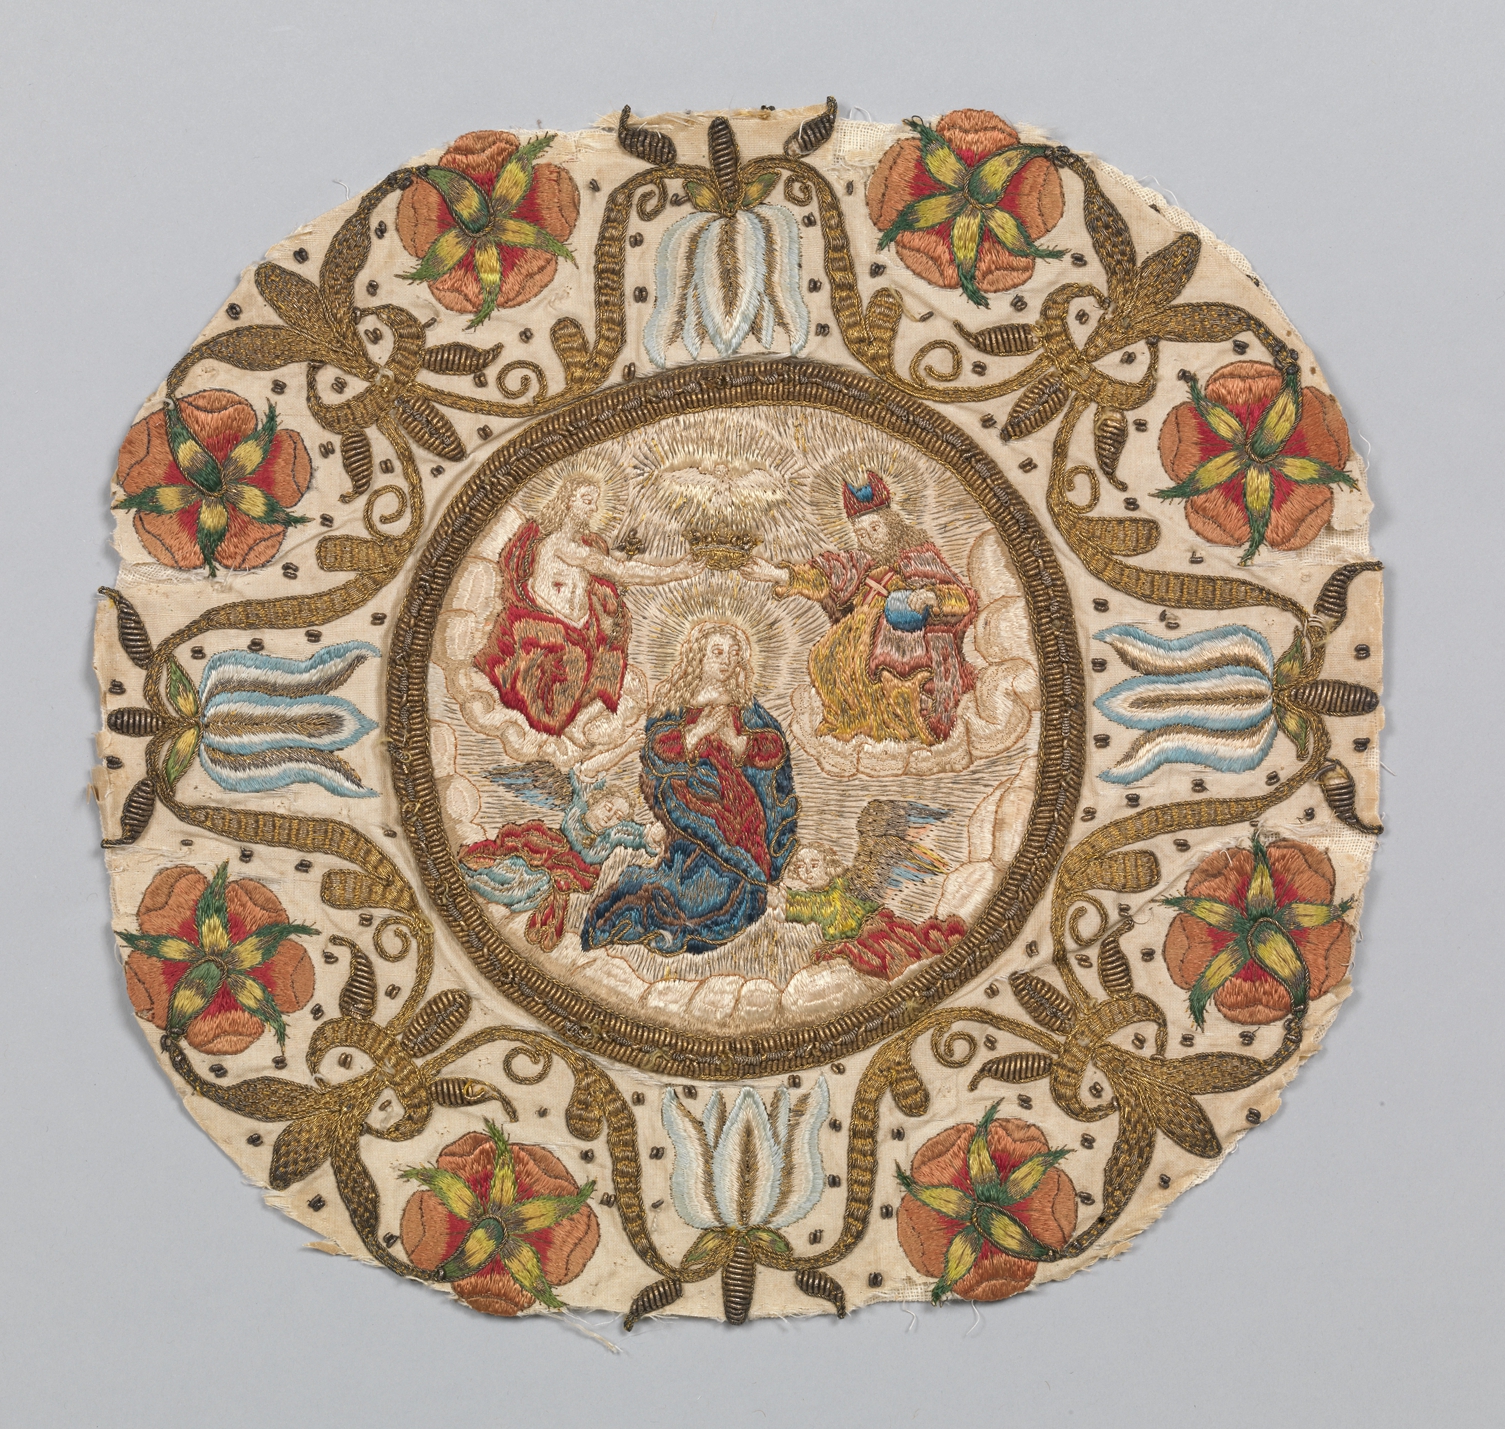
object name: medallion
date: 1501-1600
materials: metal thread, silk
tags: flowers,angels,virgin mary